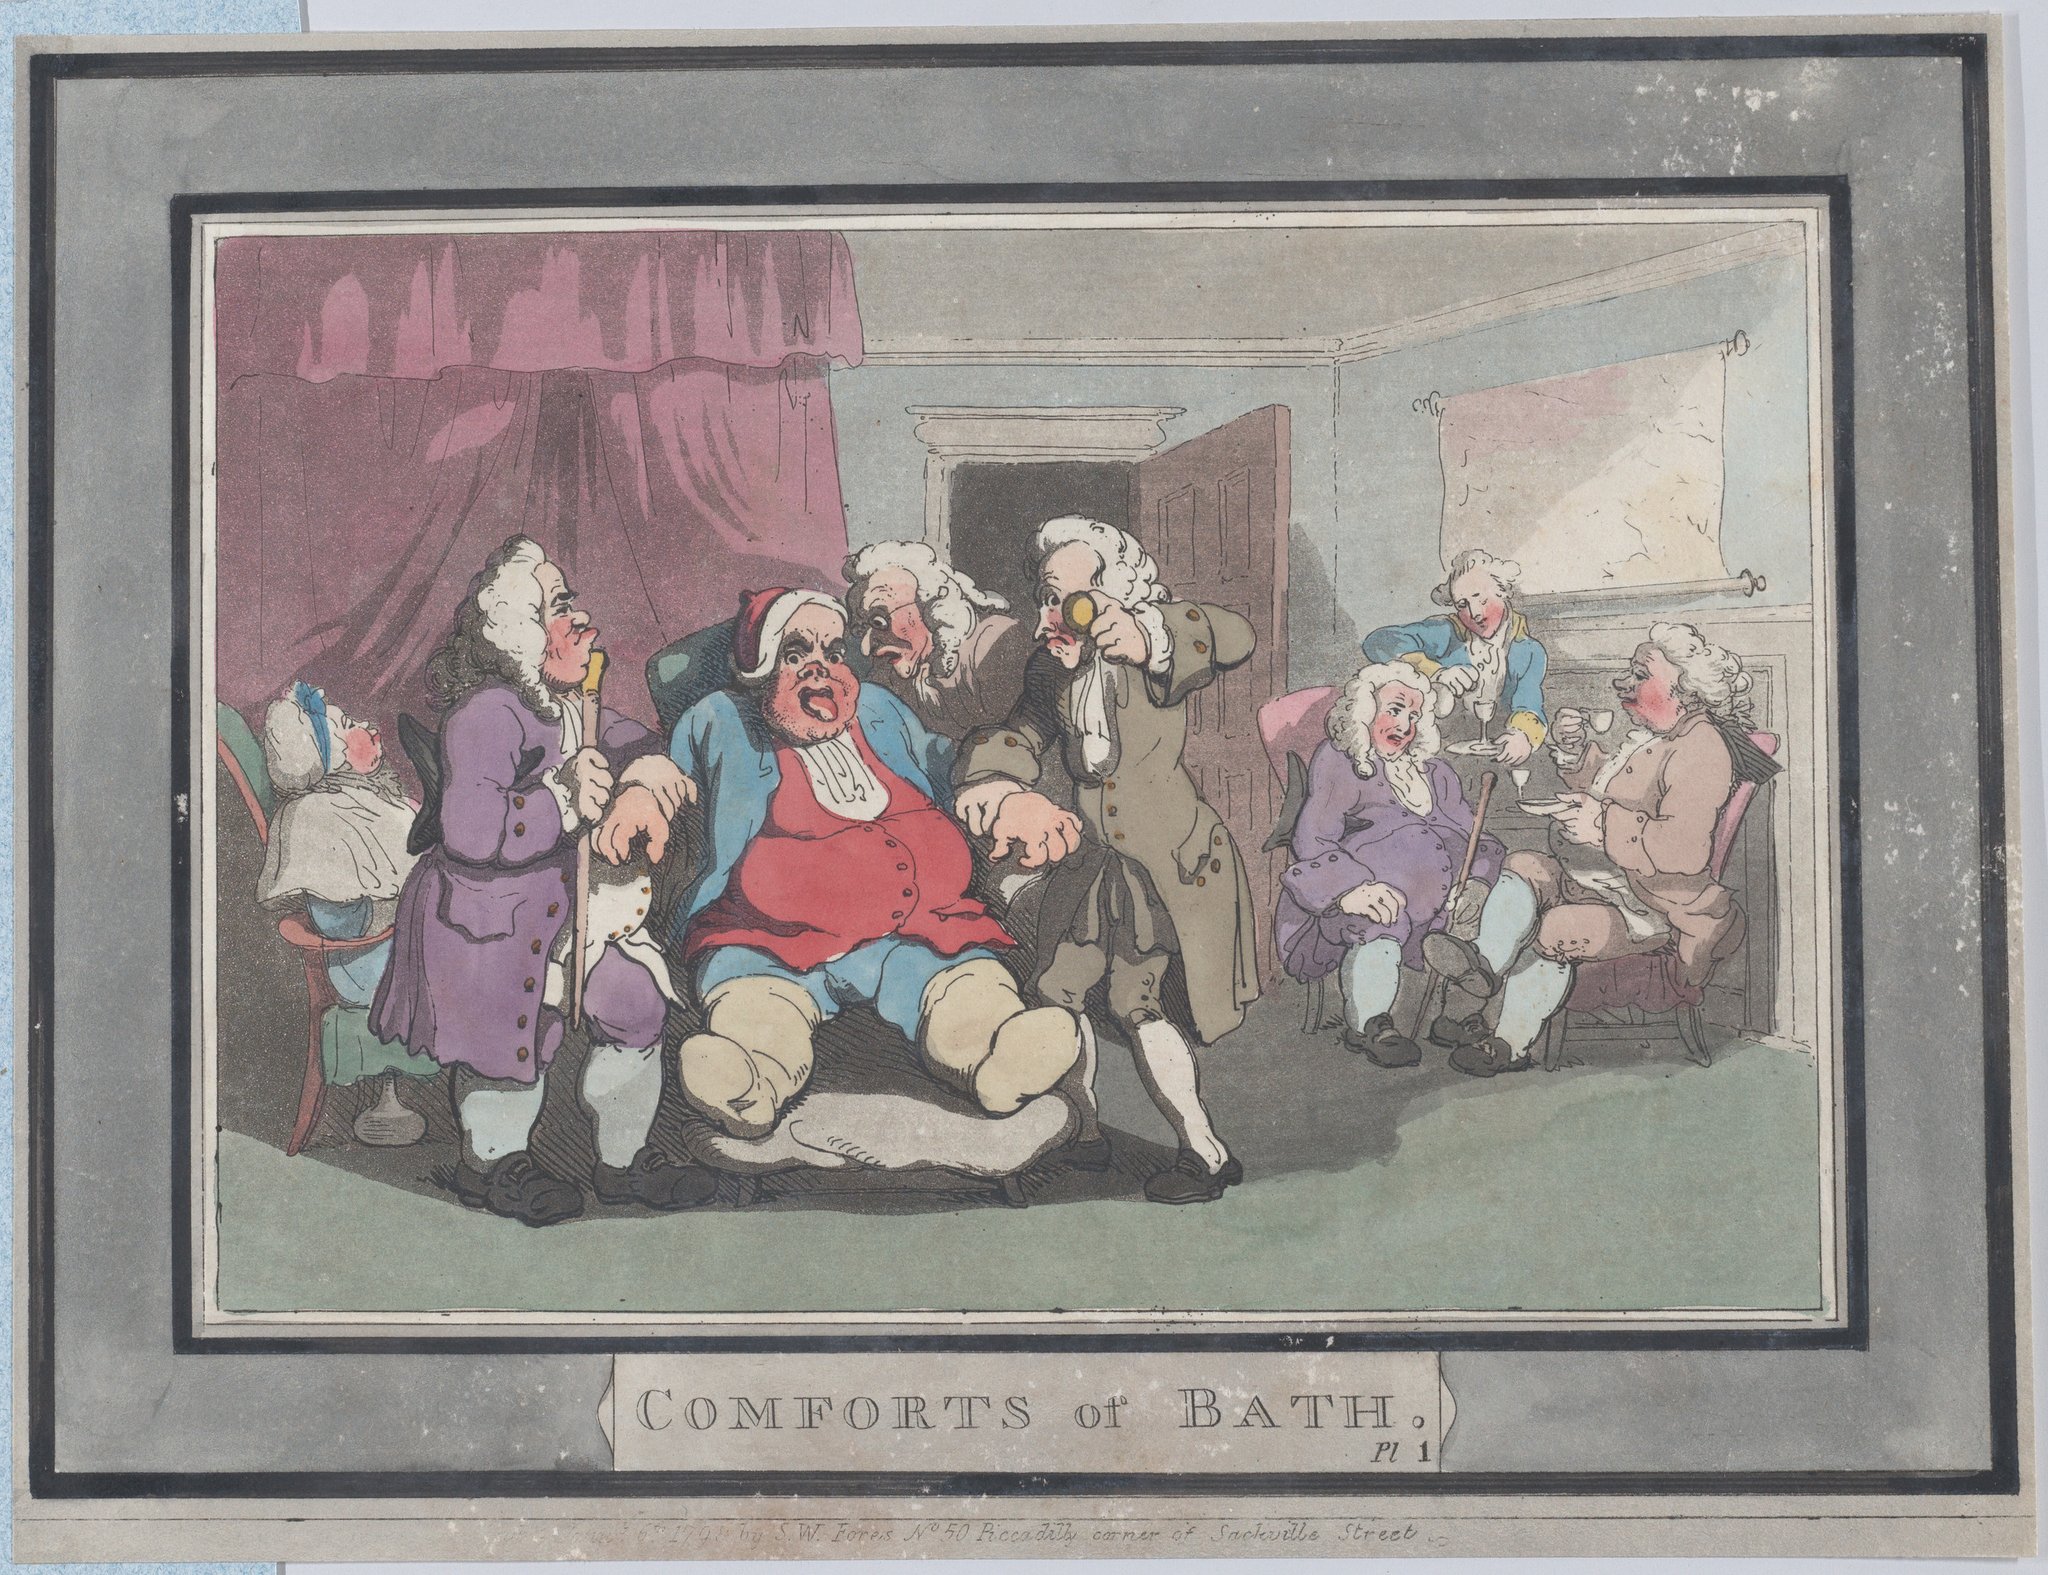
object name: print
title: Comforts of Bath, Plate 1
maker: thomas rowlandson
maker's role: artist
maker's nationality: british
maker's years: 1757-1827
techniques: aquatint, etching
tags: satire,men,women